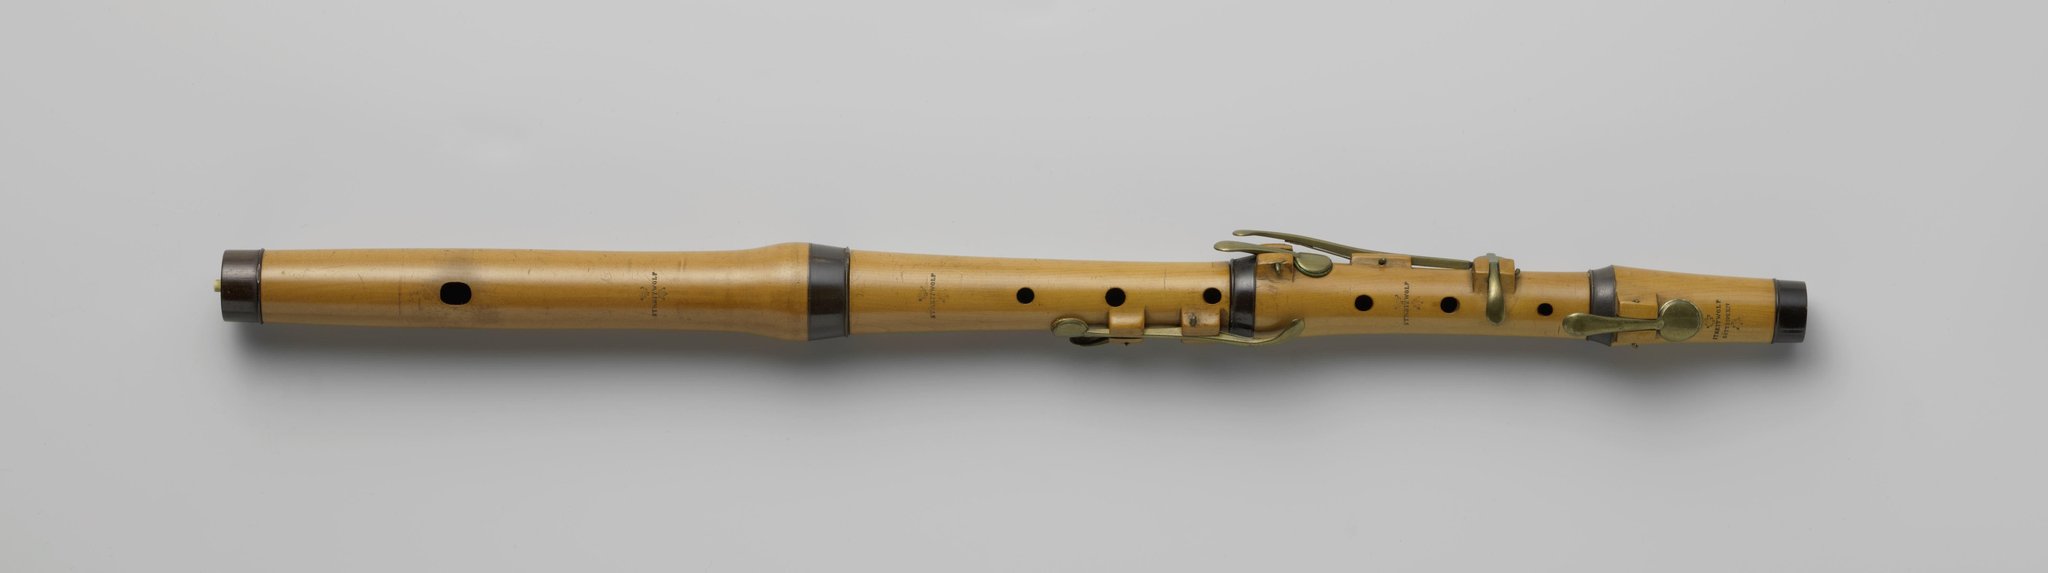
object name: wind instrument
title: Third flute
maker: johann heinrich gottlieb streitwolf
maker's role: musical instrument maker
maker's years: 1779-1837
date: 1810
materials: wood, brass, horn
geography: gottingen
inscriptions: stamp: ‘STREITWOLF/ GOTTINGEN’, stamp: ‘STREITWOLF’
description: Dwarsfluit van palmhout met vijf kleppen. Gemerkt: Streitwolf Göttingen.